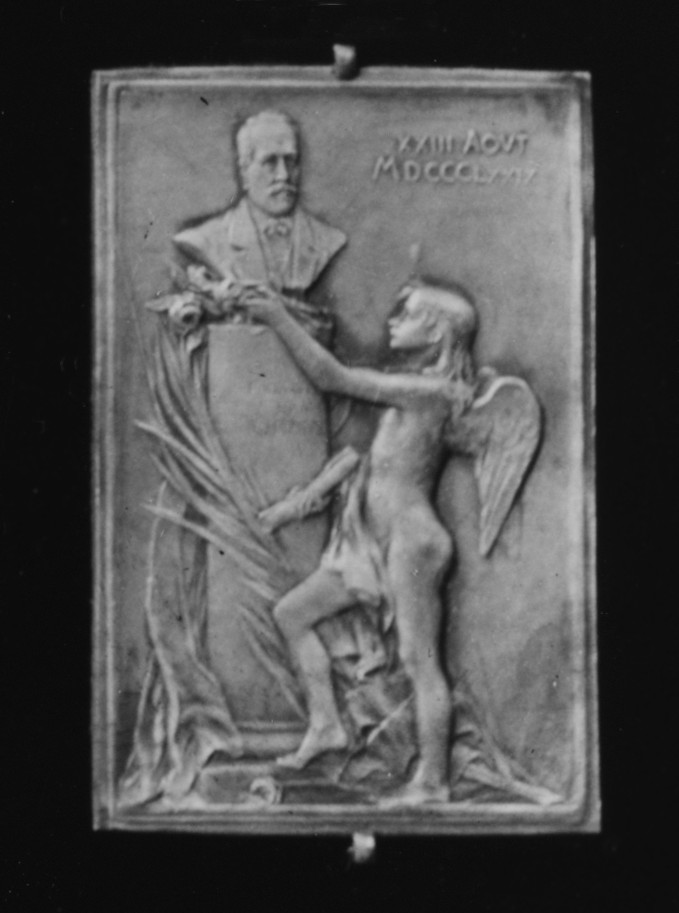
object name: plaquette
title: Award (Prix Jean Chazière) at the Academy of Lyons, 1879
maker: louis-oscar roty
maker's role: artist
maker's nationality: french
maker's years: 1846-1911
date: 1879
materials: bronze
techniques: silvered, struck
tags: men